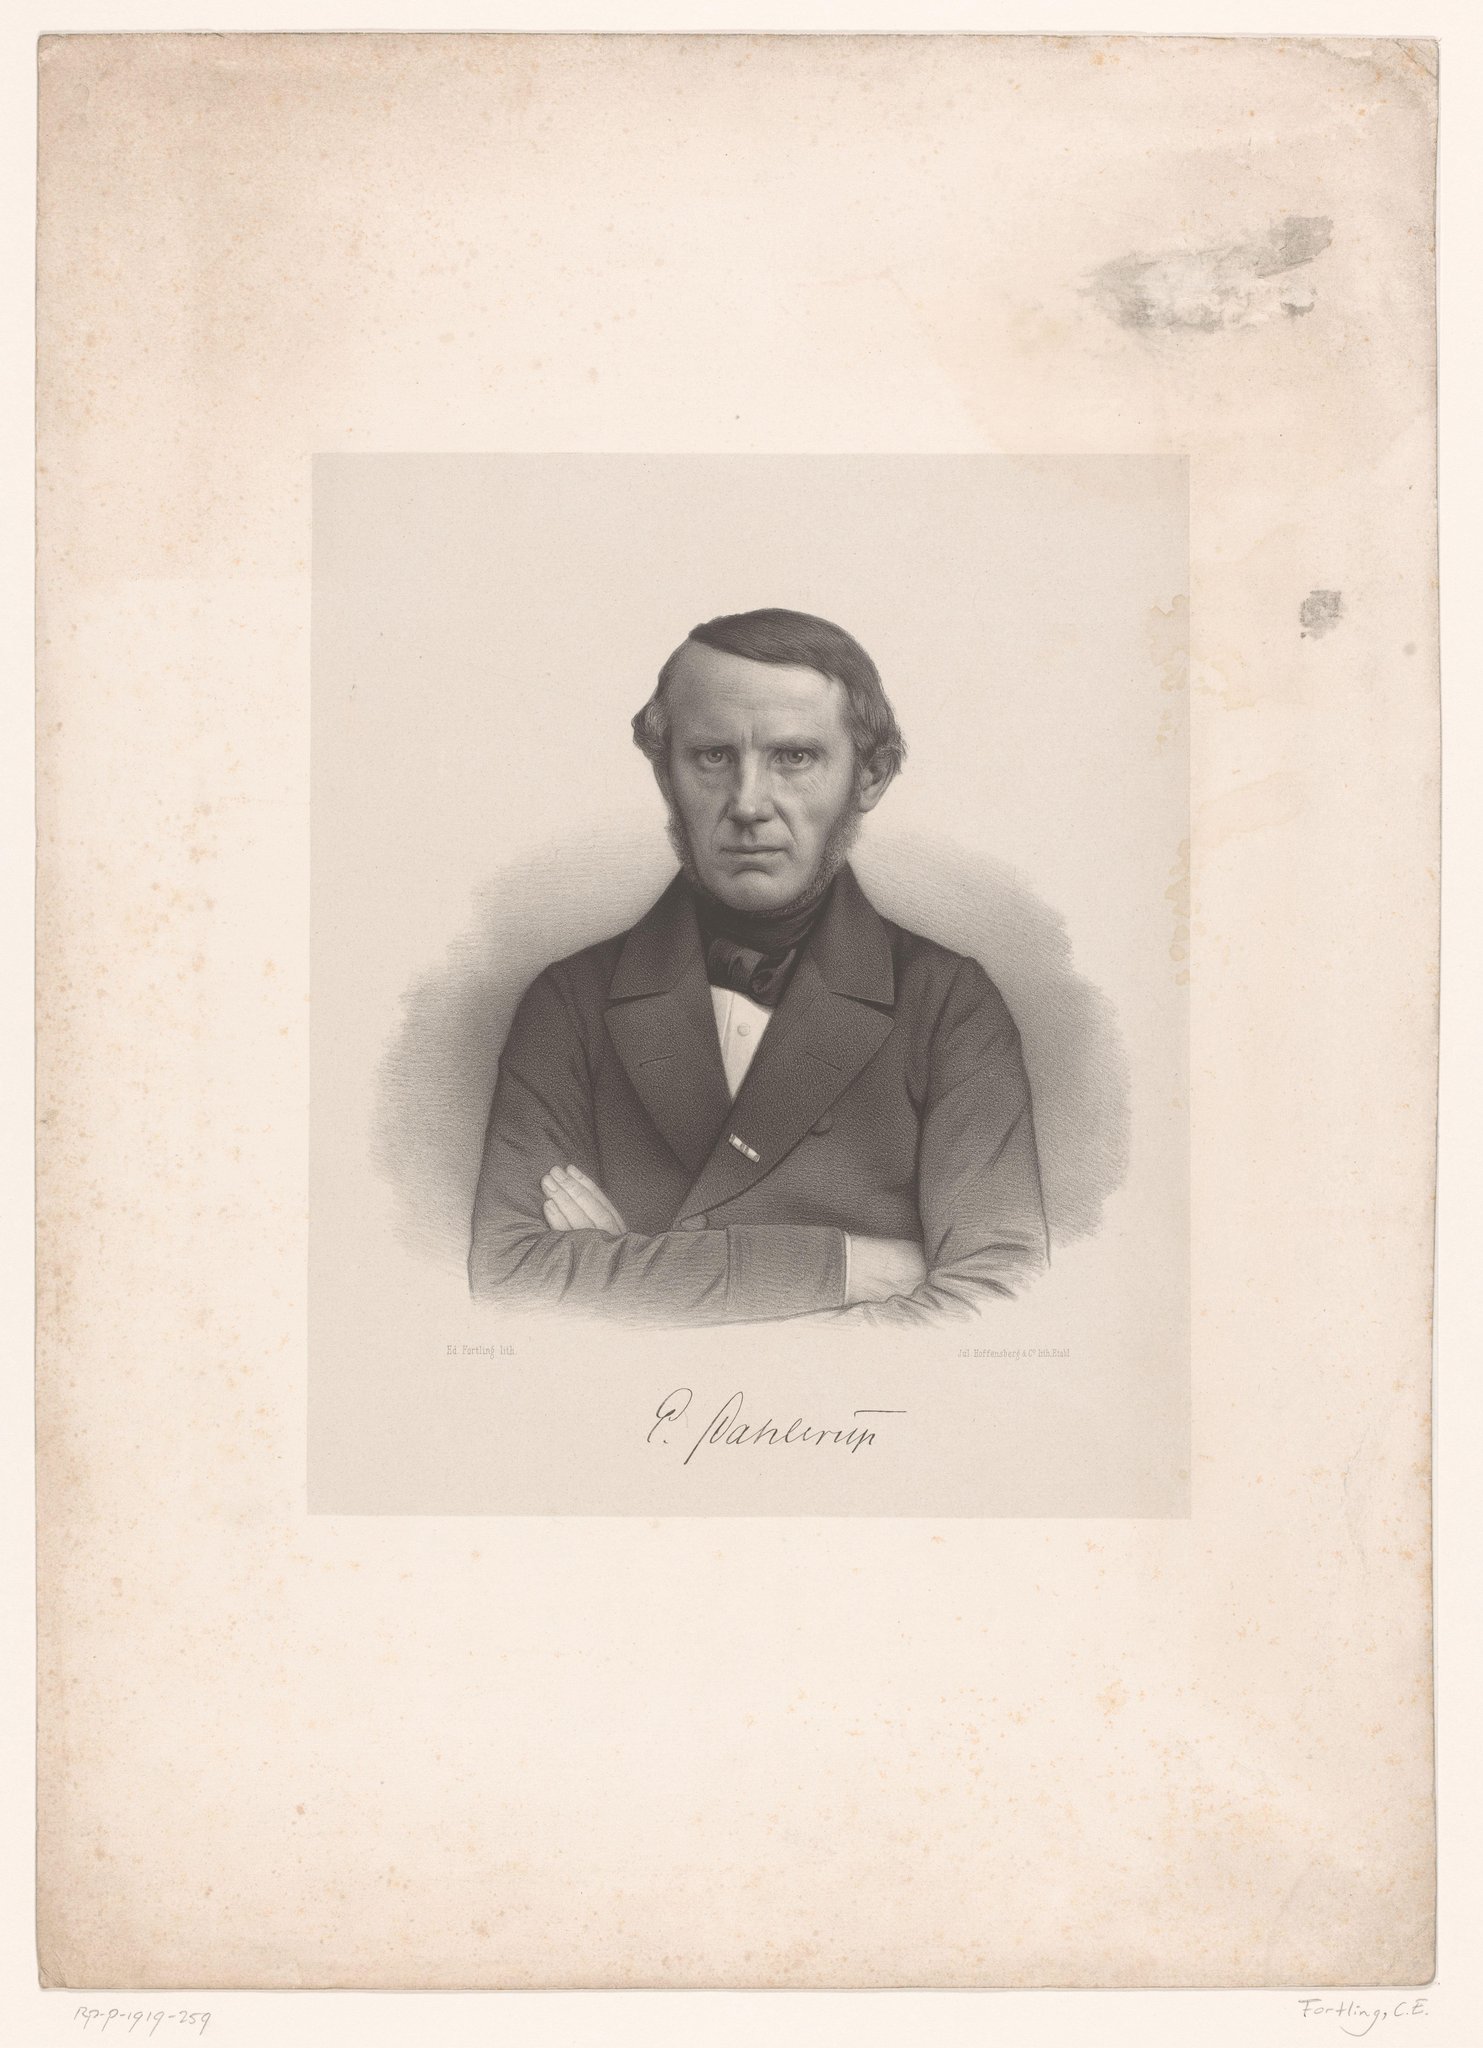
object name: print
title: Portret van Carl Emil Dahlerup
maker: christian edvard fortling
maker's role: print maker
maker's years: 1809-1875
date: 1874-1875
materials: paper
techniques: lithograph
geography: copenhagen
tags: historical persons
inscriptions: signature: ‘Jul. Hoffensberg & Co lith. Establ.’, collector's mark: Lugt 2228, inscription: ‘E. Dahlerup’, signature: ‘Ed. Fortling lith.’